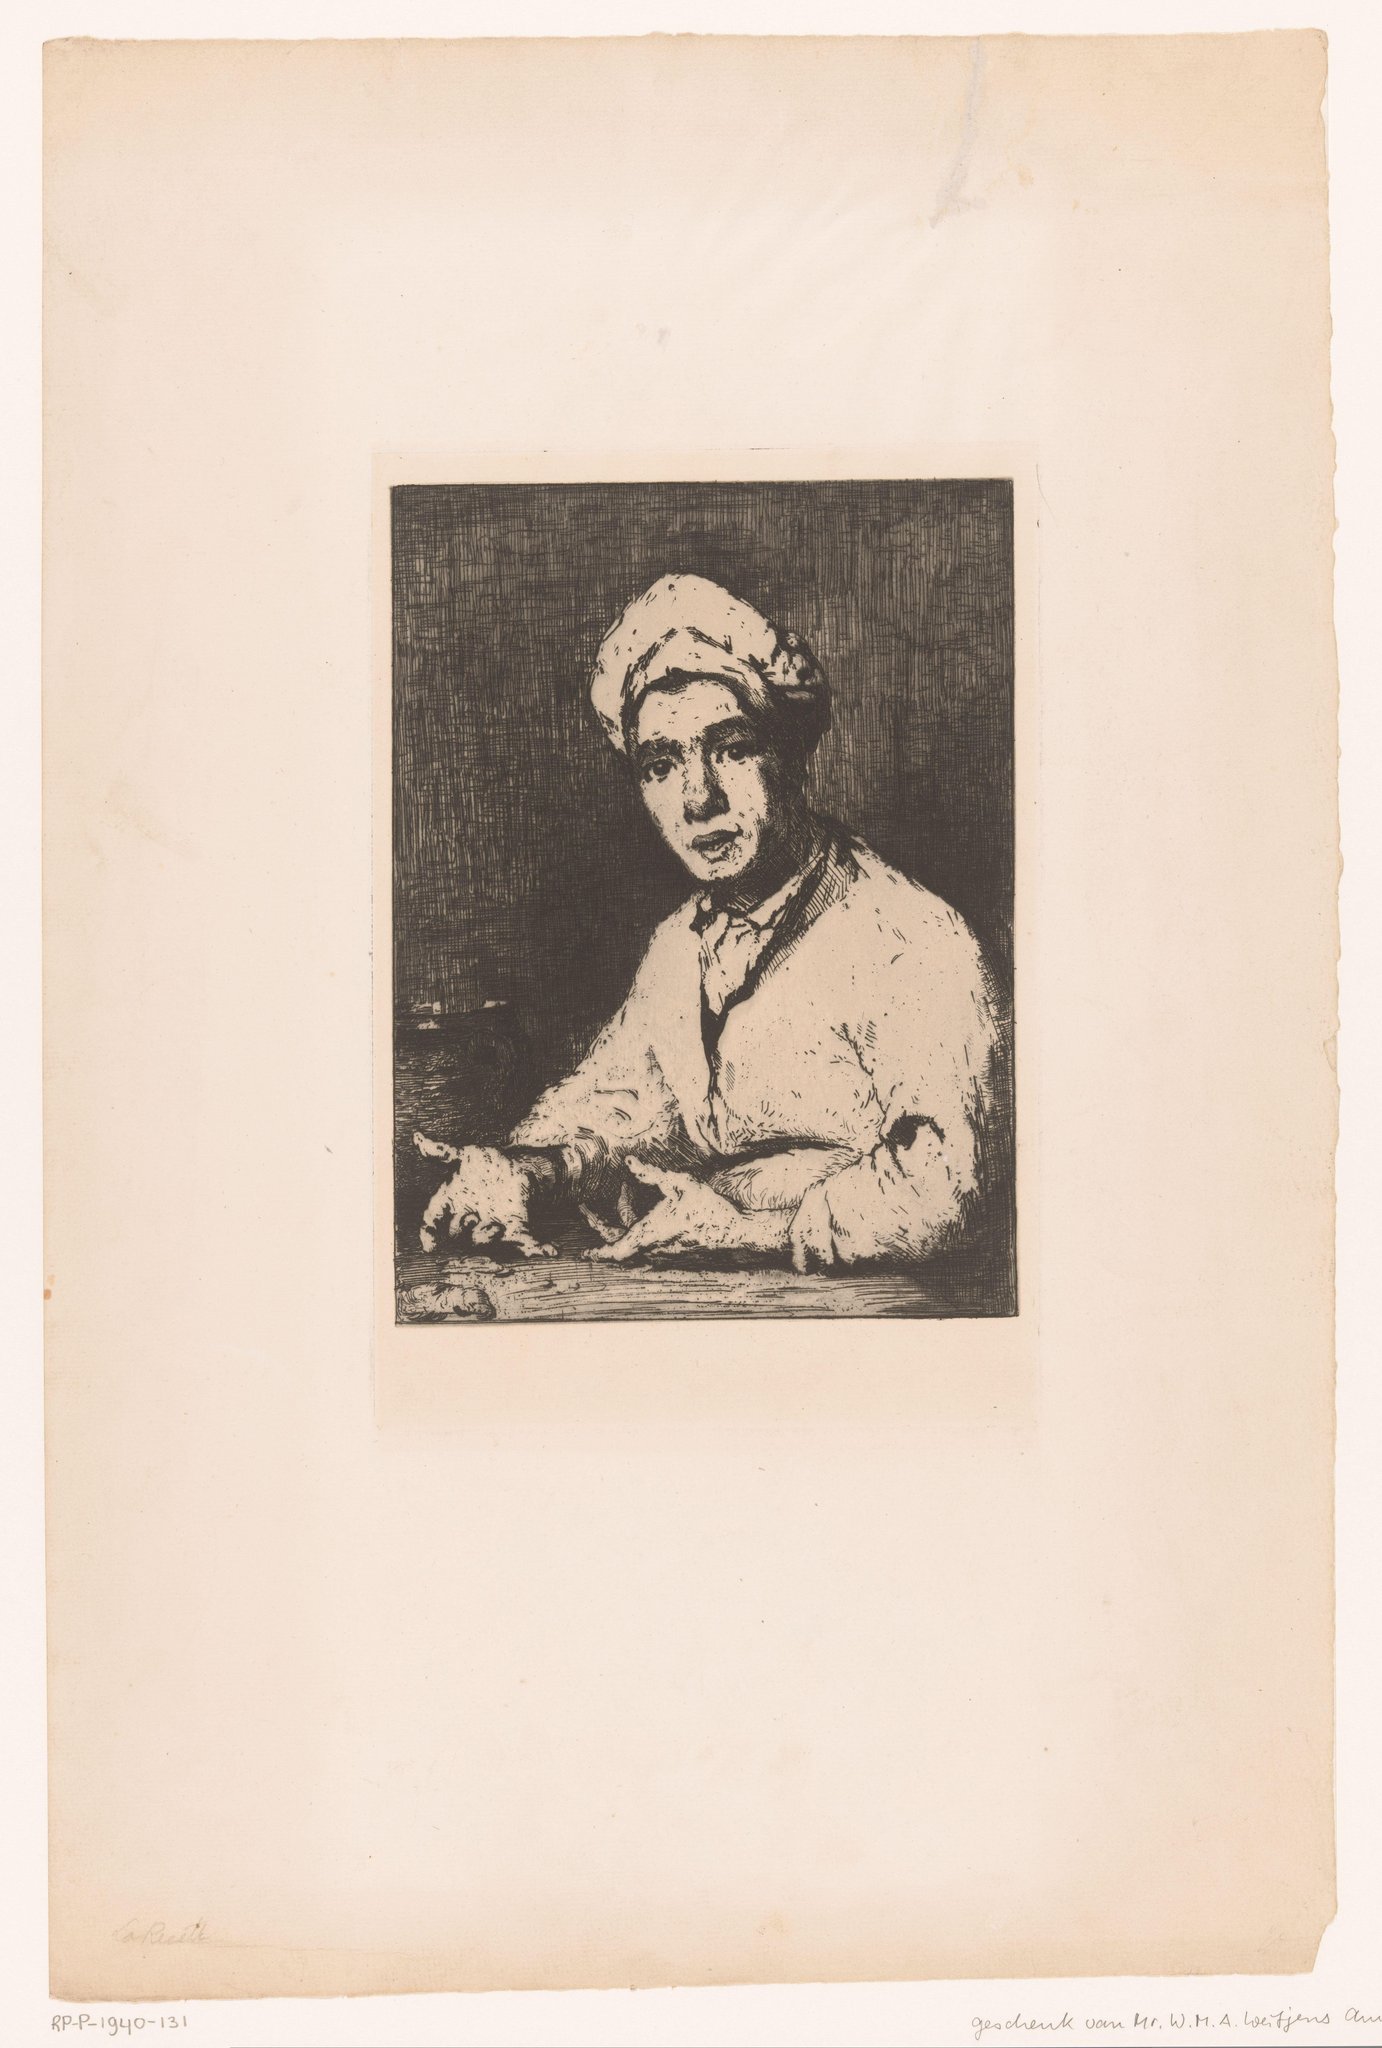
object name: print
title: La recette du cuisinier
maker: théodule augustin ribot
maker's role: draughtsman, painter, print maker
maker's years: 1823-1891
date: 1877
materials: paper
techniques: drypoint, etching, intaglio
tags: cook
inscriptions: collector's mark: Lugt 2166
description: Maakt volgens het British Museum deel uit van het een serie prenten door de Société des Aquafortistes uit 1877. Plaatnummer onbekend.